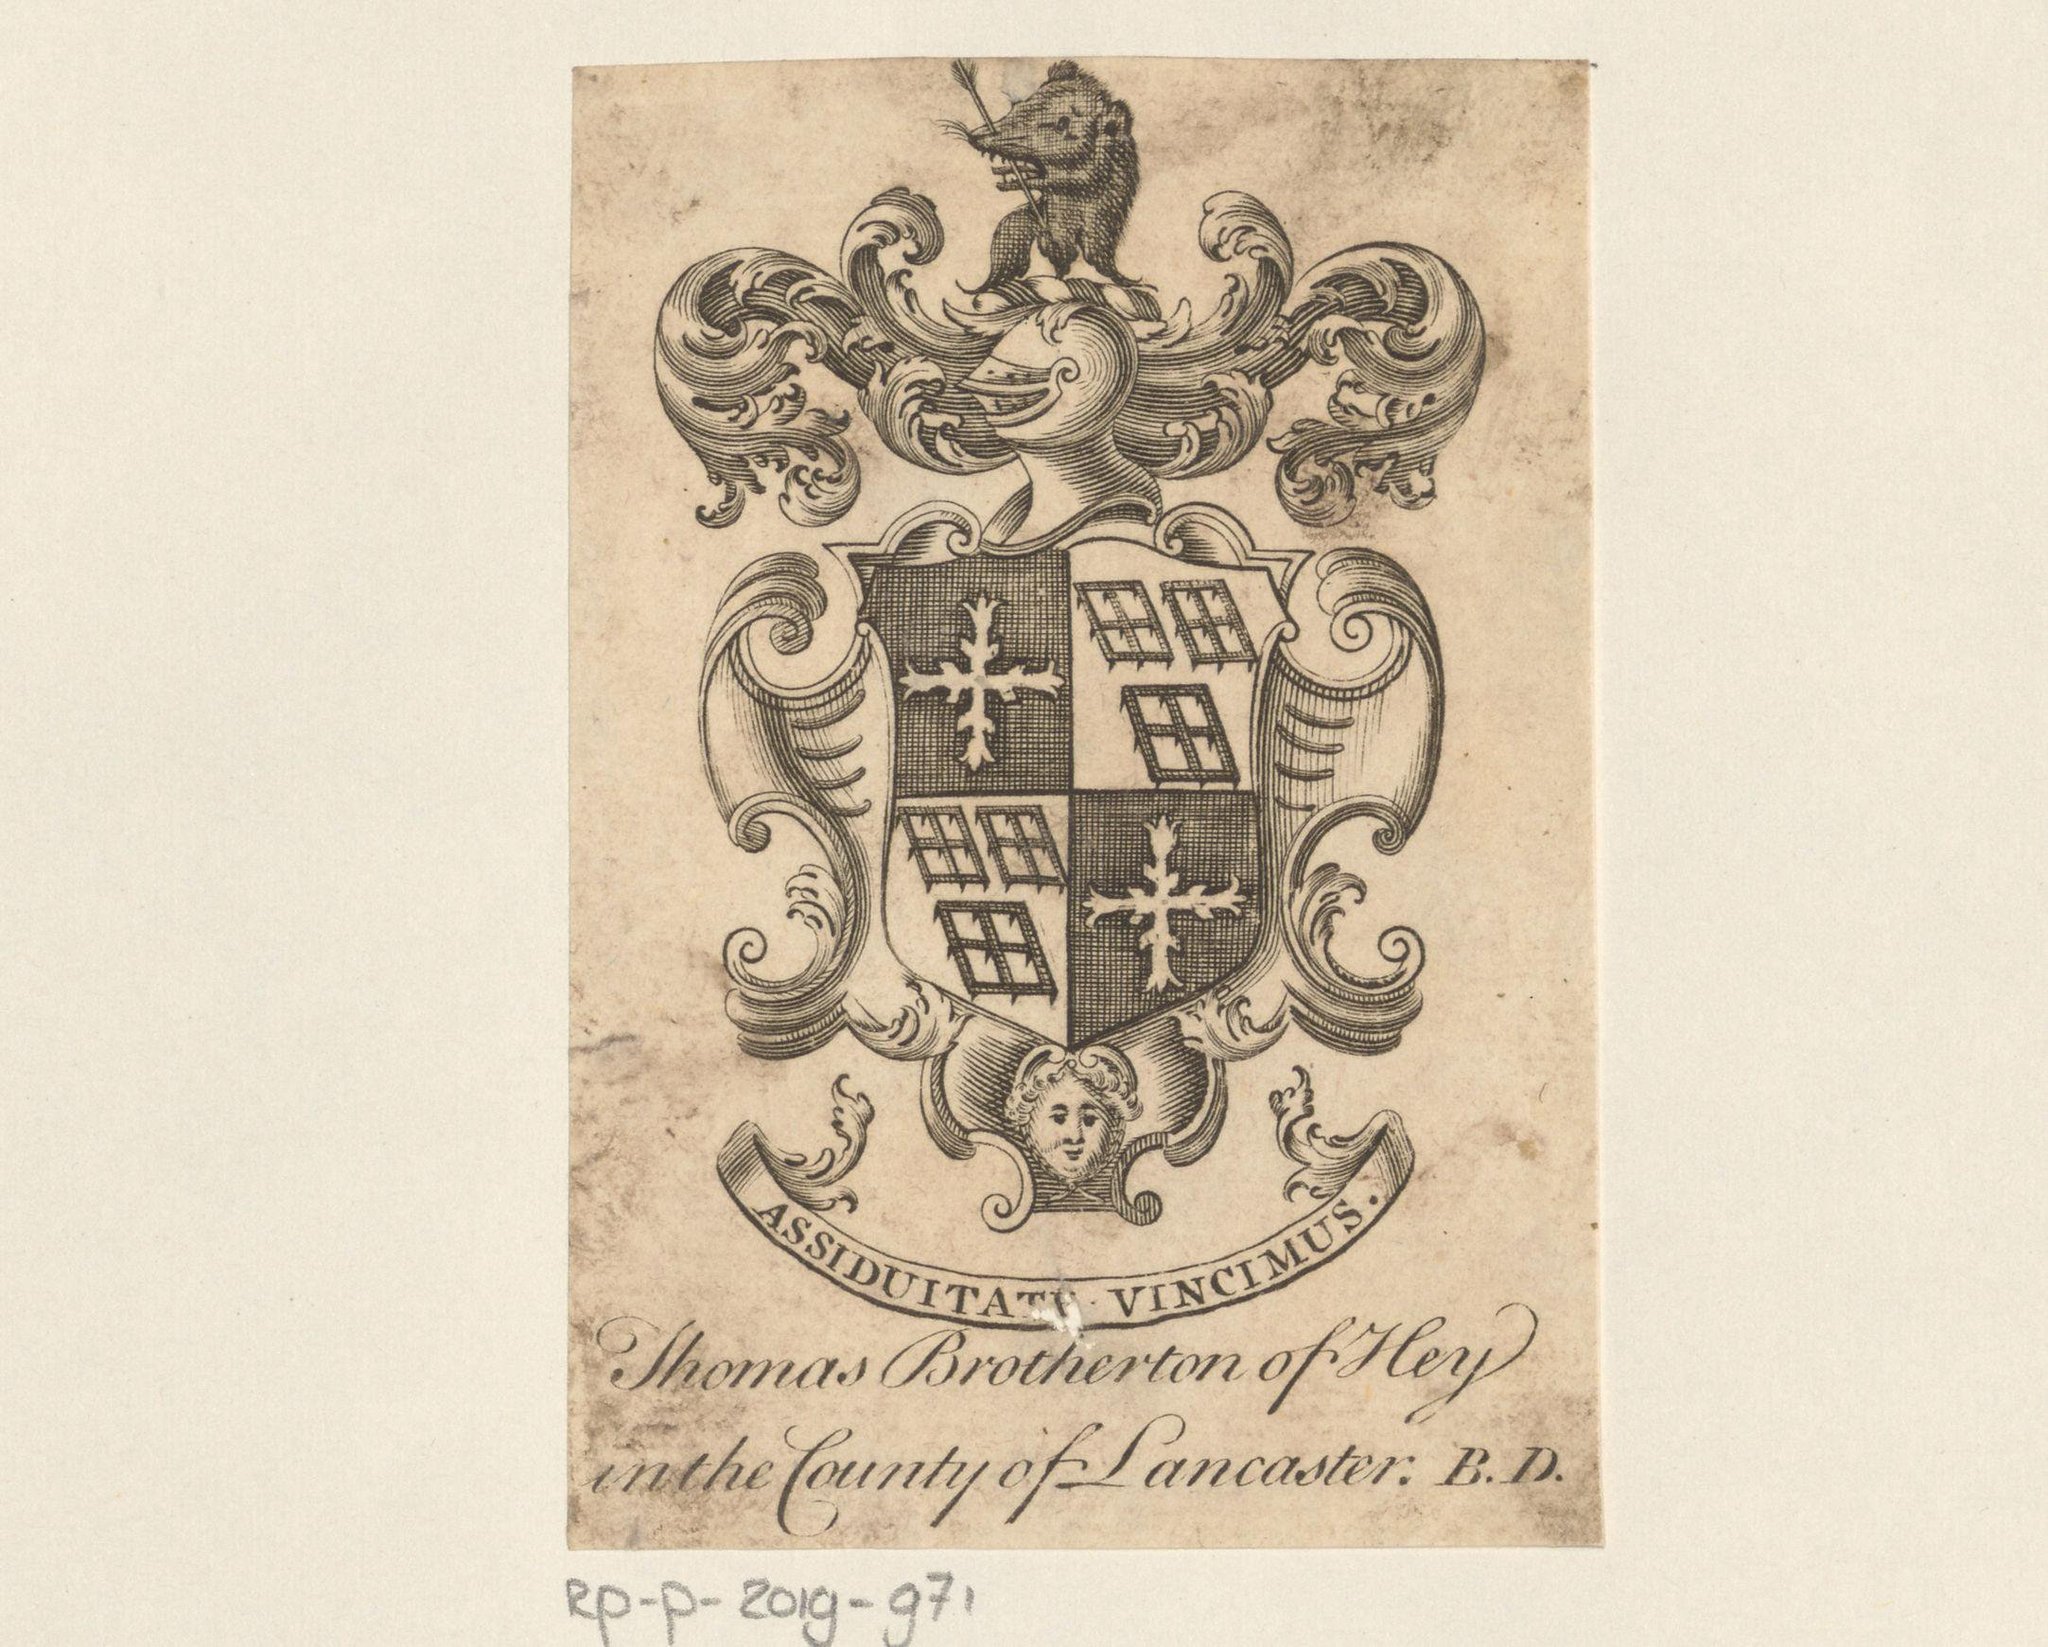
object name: bookplate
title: Ex libris van Thomas Brotherton of Hey in the County of Lancaster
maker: Anonymous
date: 1700-1799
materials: paper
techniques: engraving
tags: armorial bearing, heraldry